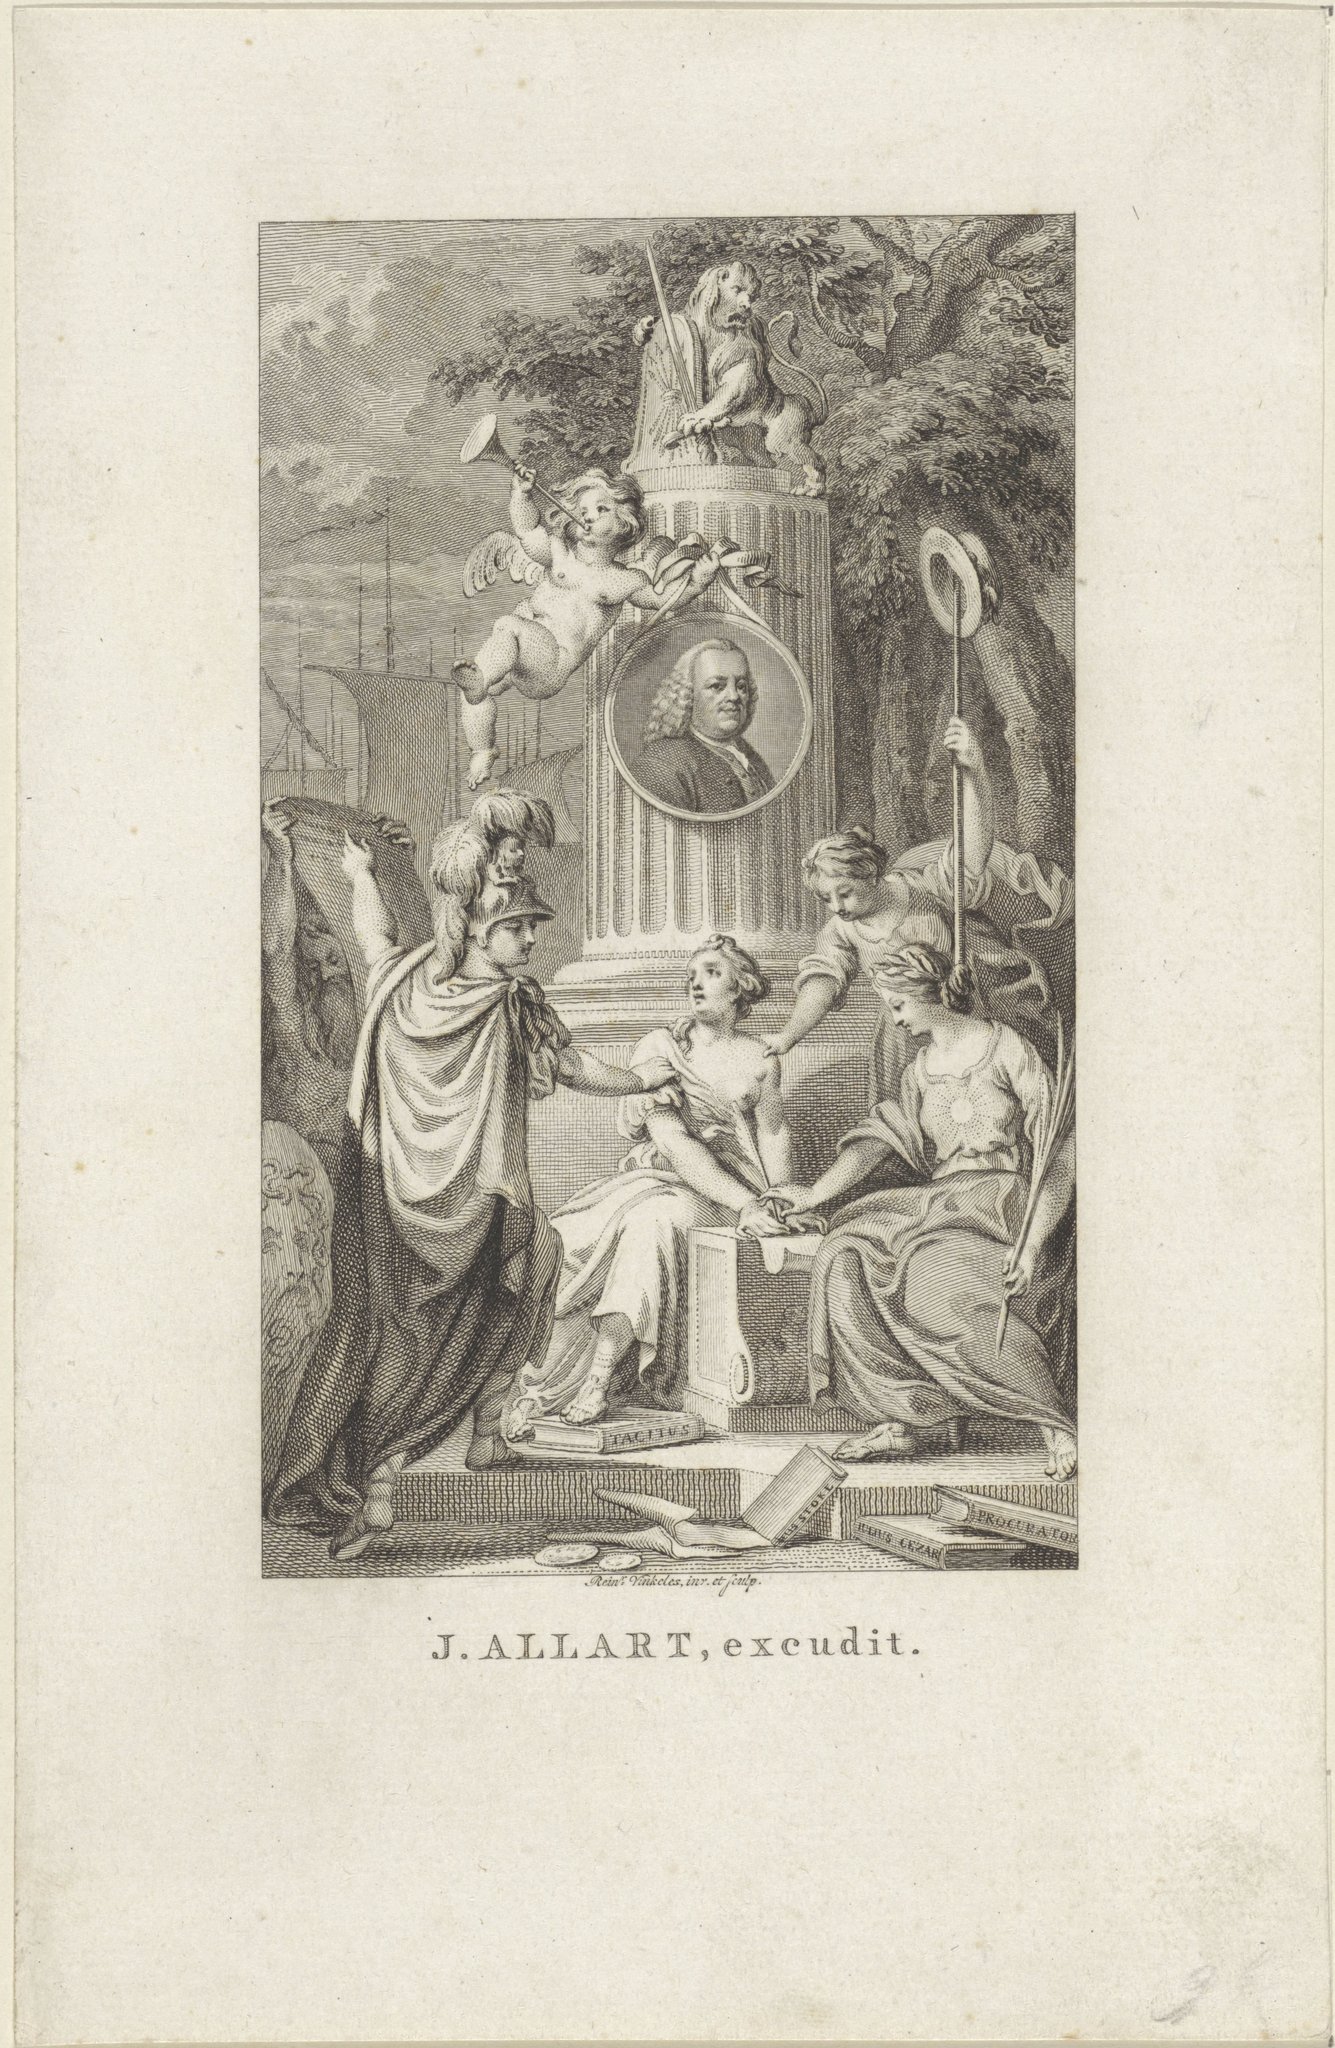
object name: titelblad, titelpagina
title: Portret van Jan Wagenaar met allegorische figuren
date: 1788-1790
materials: paper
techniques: engraving, etching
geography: amsterdam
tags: amsterdam, jan wagenaar, truth; 'verità' (ripa), 'historia'; 'historia' (ripa), freedom, liberty; 'libertà' (ripa)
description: Geschiedenis schrijft omringd door de Waarheid, Vrijheid en Minerva. Achter hen een zuil met het portret van de schrijver Jan Wagenaar.